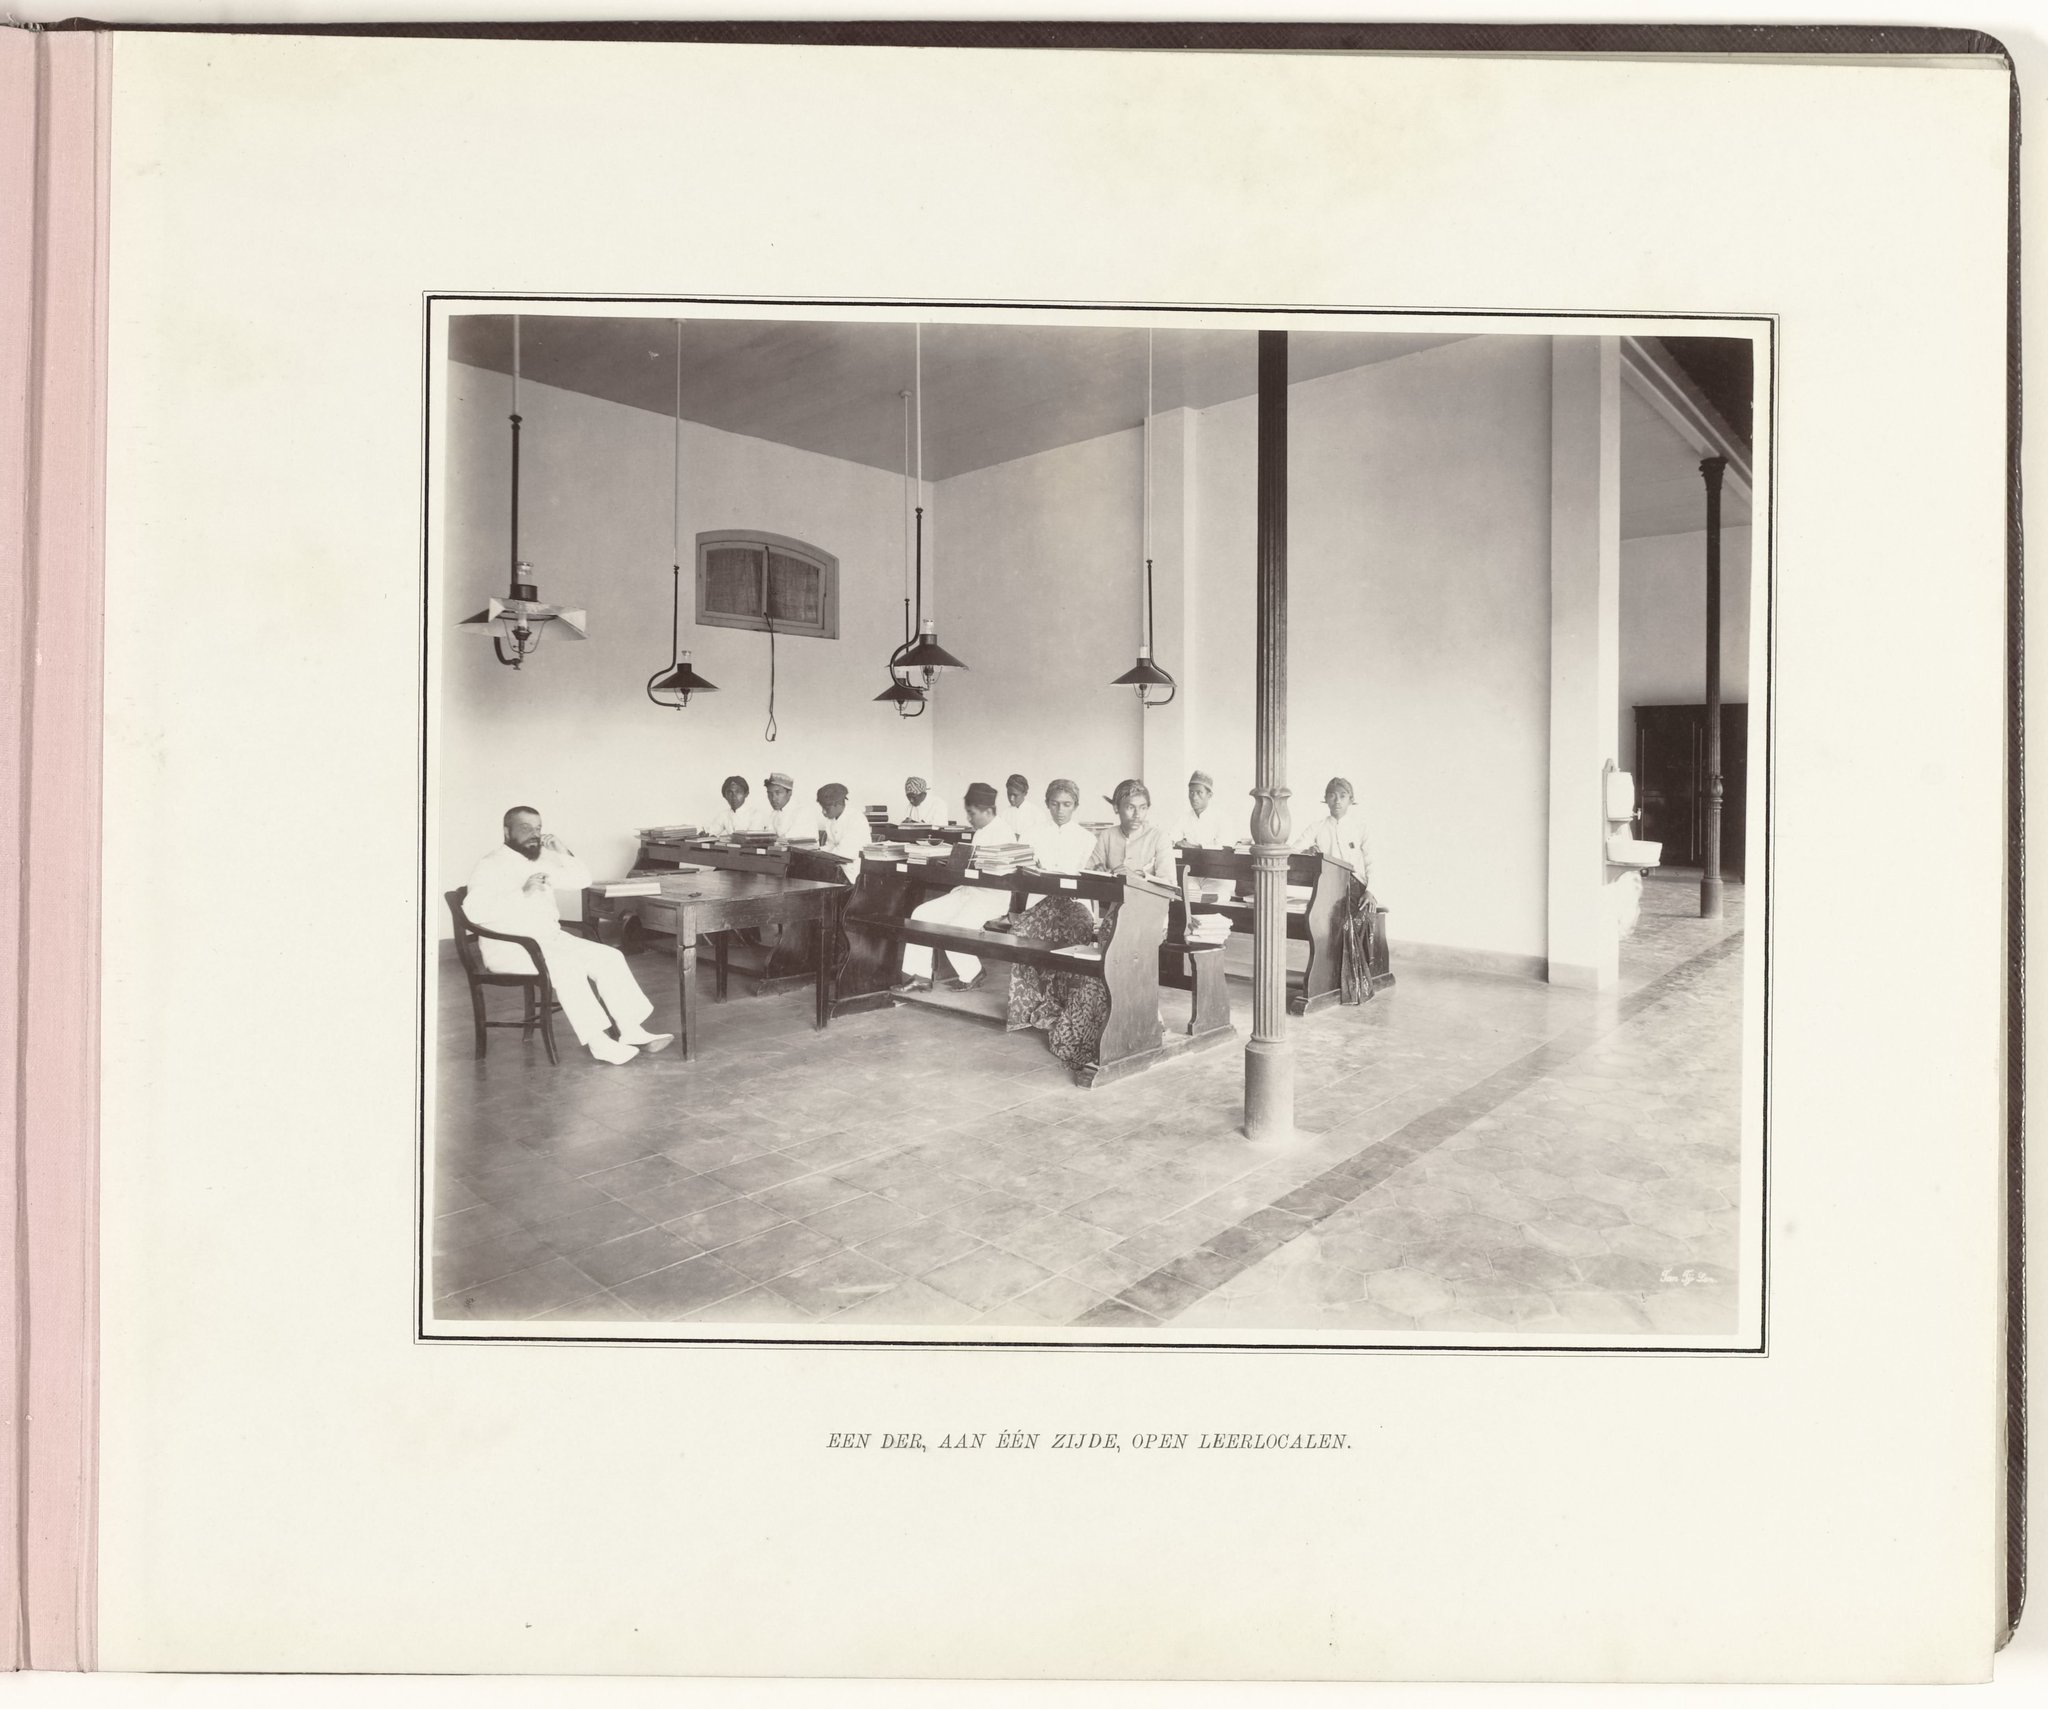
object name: photograph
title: Een der, aan één zijde, open leerlocalen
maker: tan tjie lan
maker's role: fotograaf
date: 1902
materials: photographic support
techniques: albumen print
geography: weltevreden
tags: colonial system, vocational education, e.g.: junior technical school, vocational education, e.g.: junior technical school (+ pupil)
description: Een aan één zijde open lokaal van de School tot Opleiding van Inlandse Artsen (STOVIA) te Weltevreden. Lokaal met directeur H.F. Roll en leerlingen. Ingeplakte foto in het album van ca. 1902 getiteld: School tot Opleiding van Inlandsche Geneeskundigen / Ter Herinnering aan de Inhuldiging van Koningin Wilhelmina en tot Heil der Bevolking van Nederlandsch Oost-Indie.